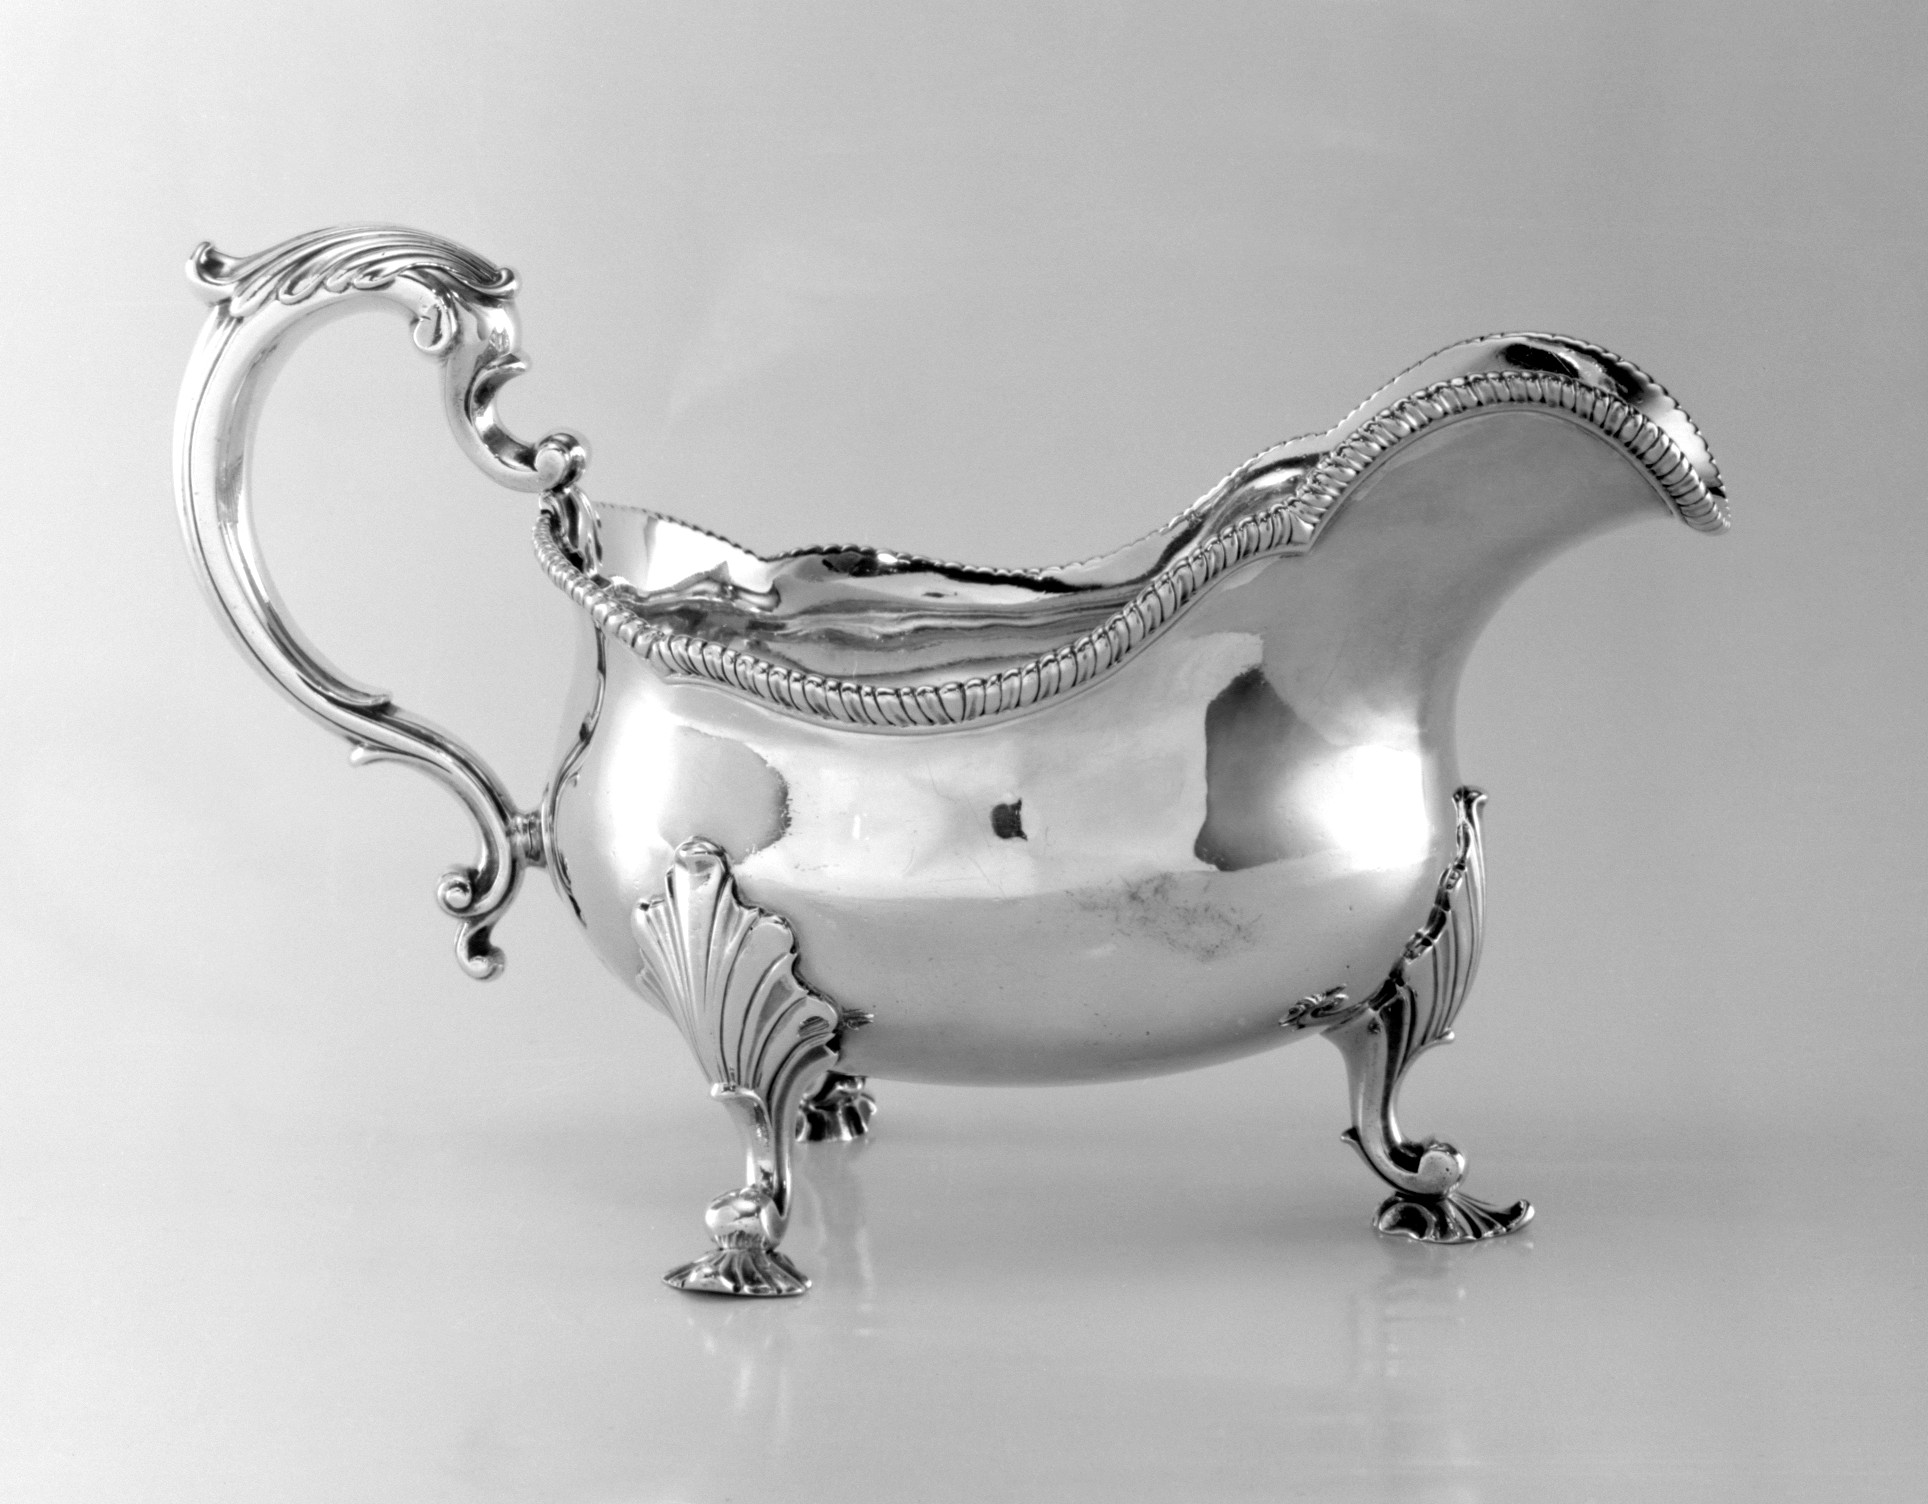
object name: sauceboat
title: Pair of sauceboats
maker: john parker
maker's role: maker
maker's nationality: british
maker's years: 1759-1777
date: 1761-1762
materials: silver